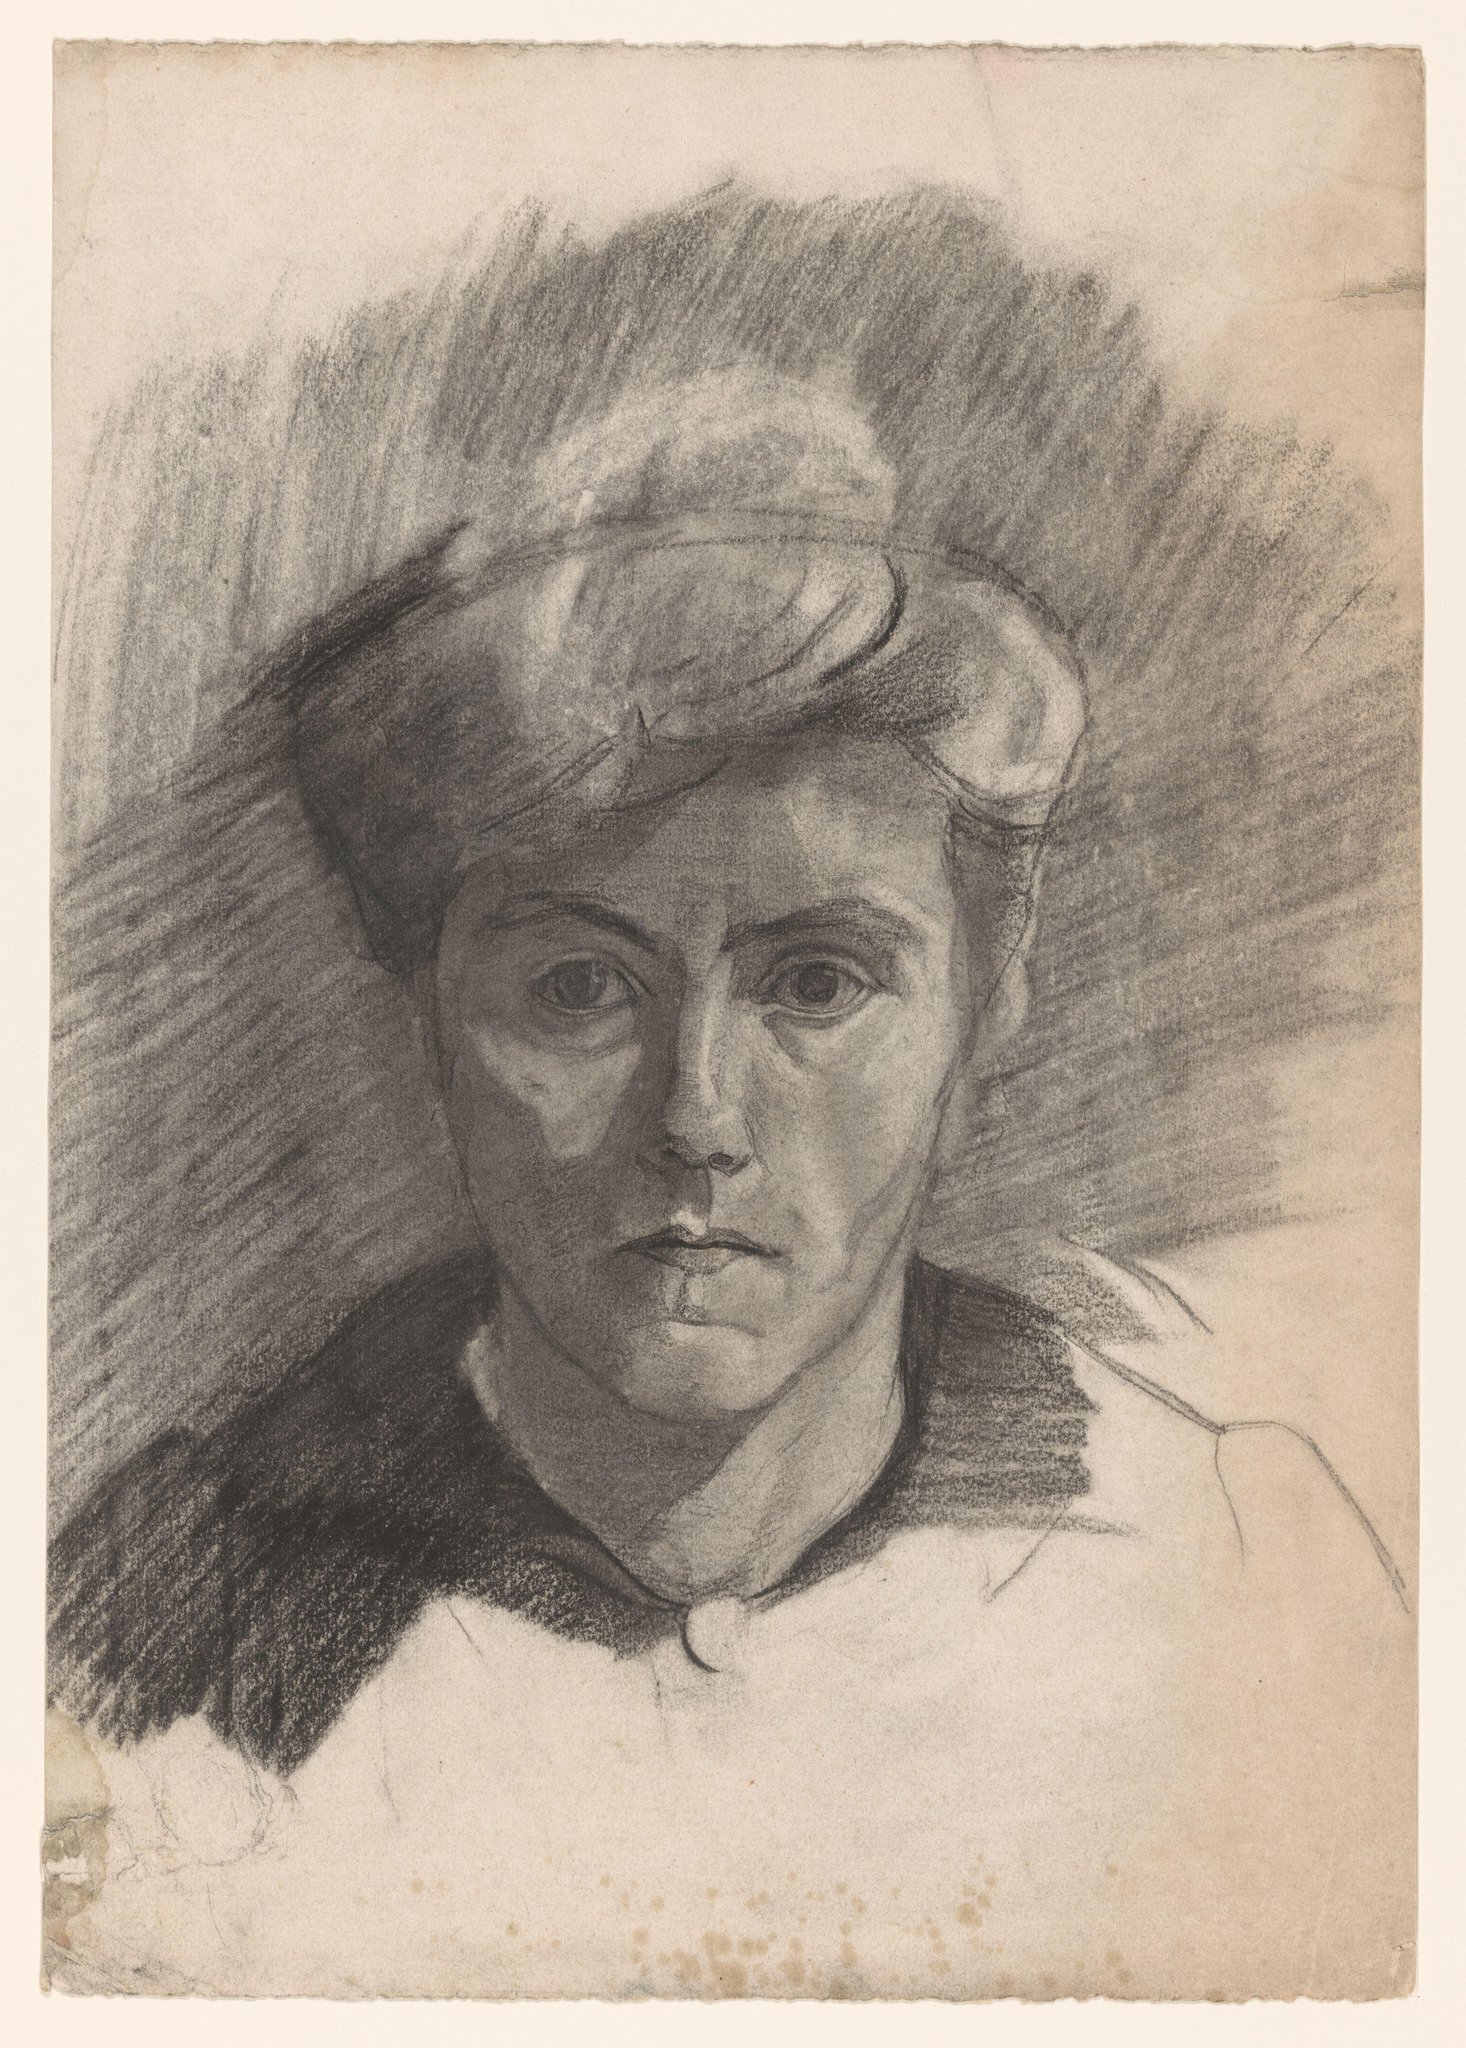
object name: drawing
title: Portret van een vrouw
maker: coba steenhoff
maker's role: draughtsman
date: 1800-1900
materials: chalk, paper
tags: anonymous historical person portrayed alone